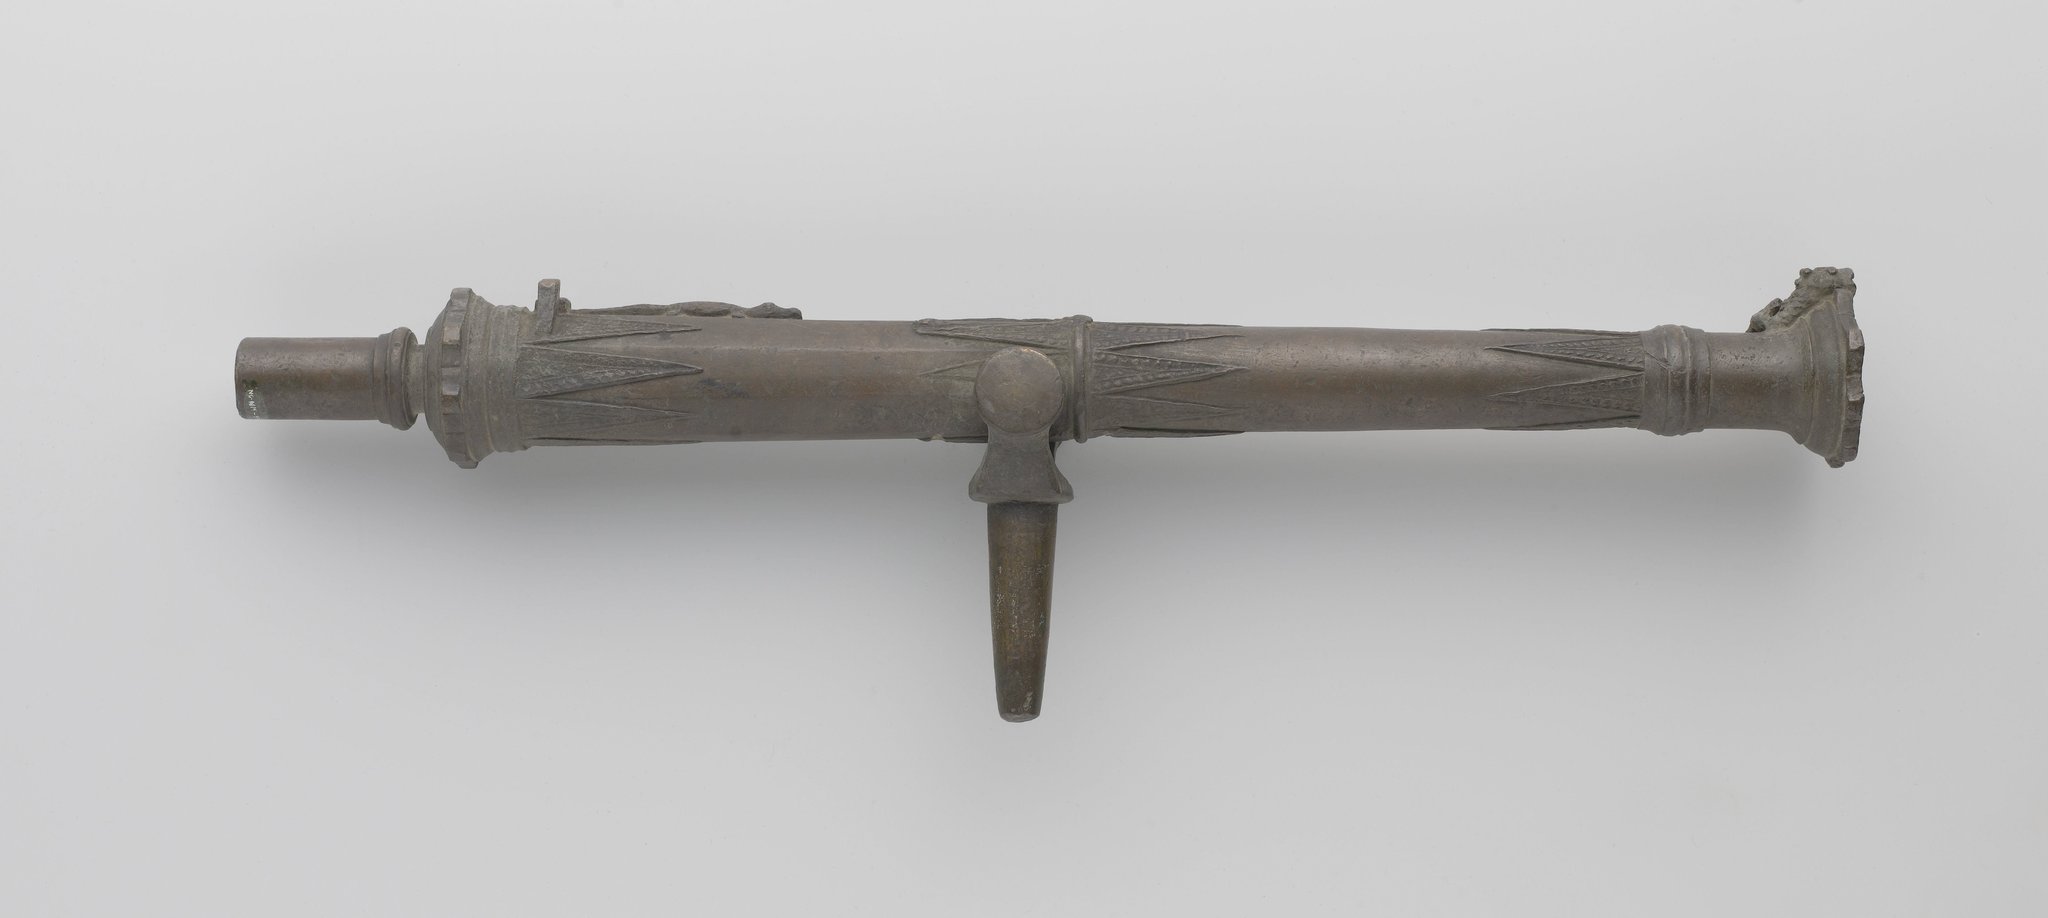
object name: lilla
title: Captured Ordnance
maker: Anonymous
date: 1667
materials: bronze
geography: indonesian archipelago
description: After Java was brought entirely under Dutch rule during the Java War (1825–1830), the Dutch sought to gain control of the other Indonesian islands as well. Various military expeditions were mounted to force the rulers of these islands to recognize Dutch authority. These cannons were seized during those battles. One is an old Dutch East India Company cannon of 1667.